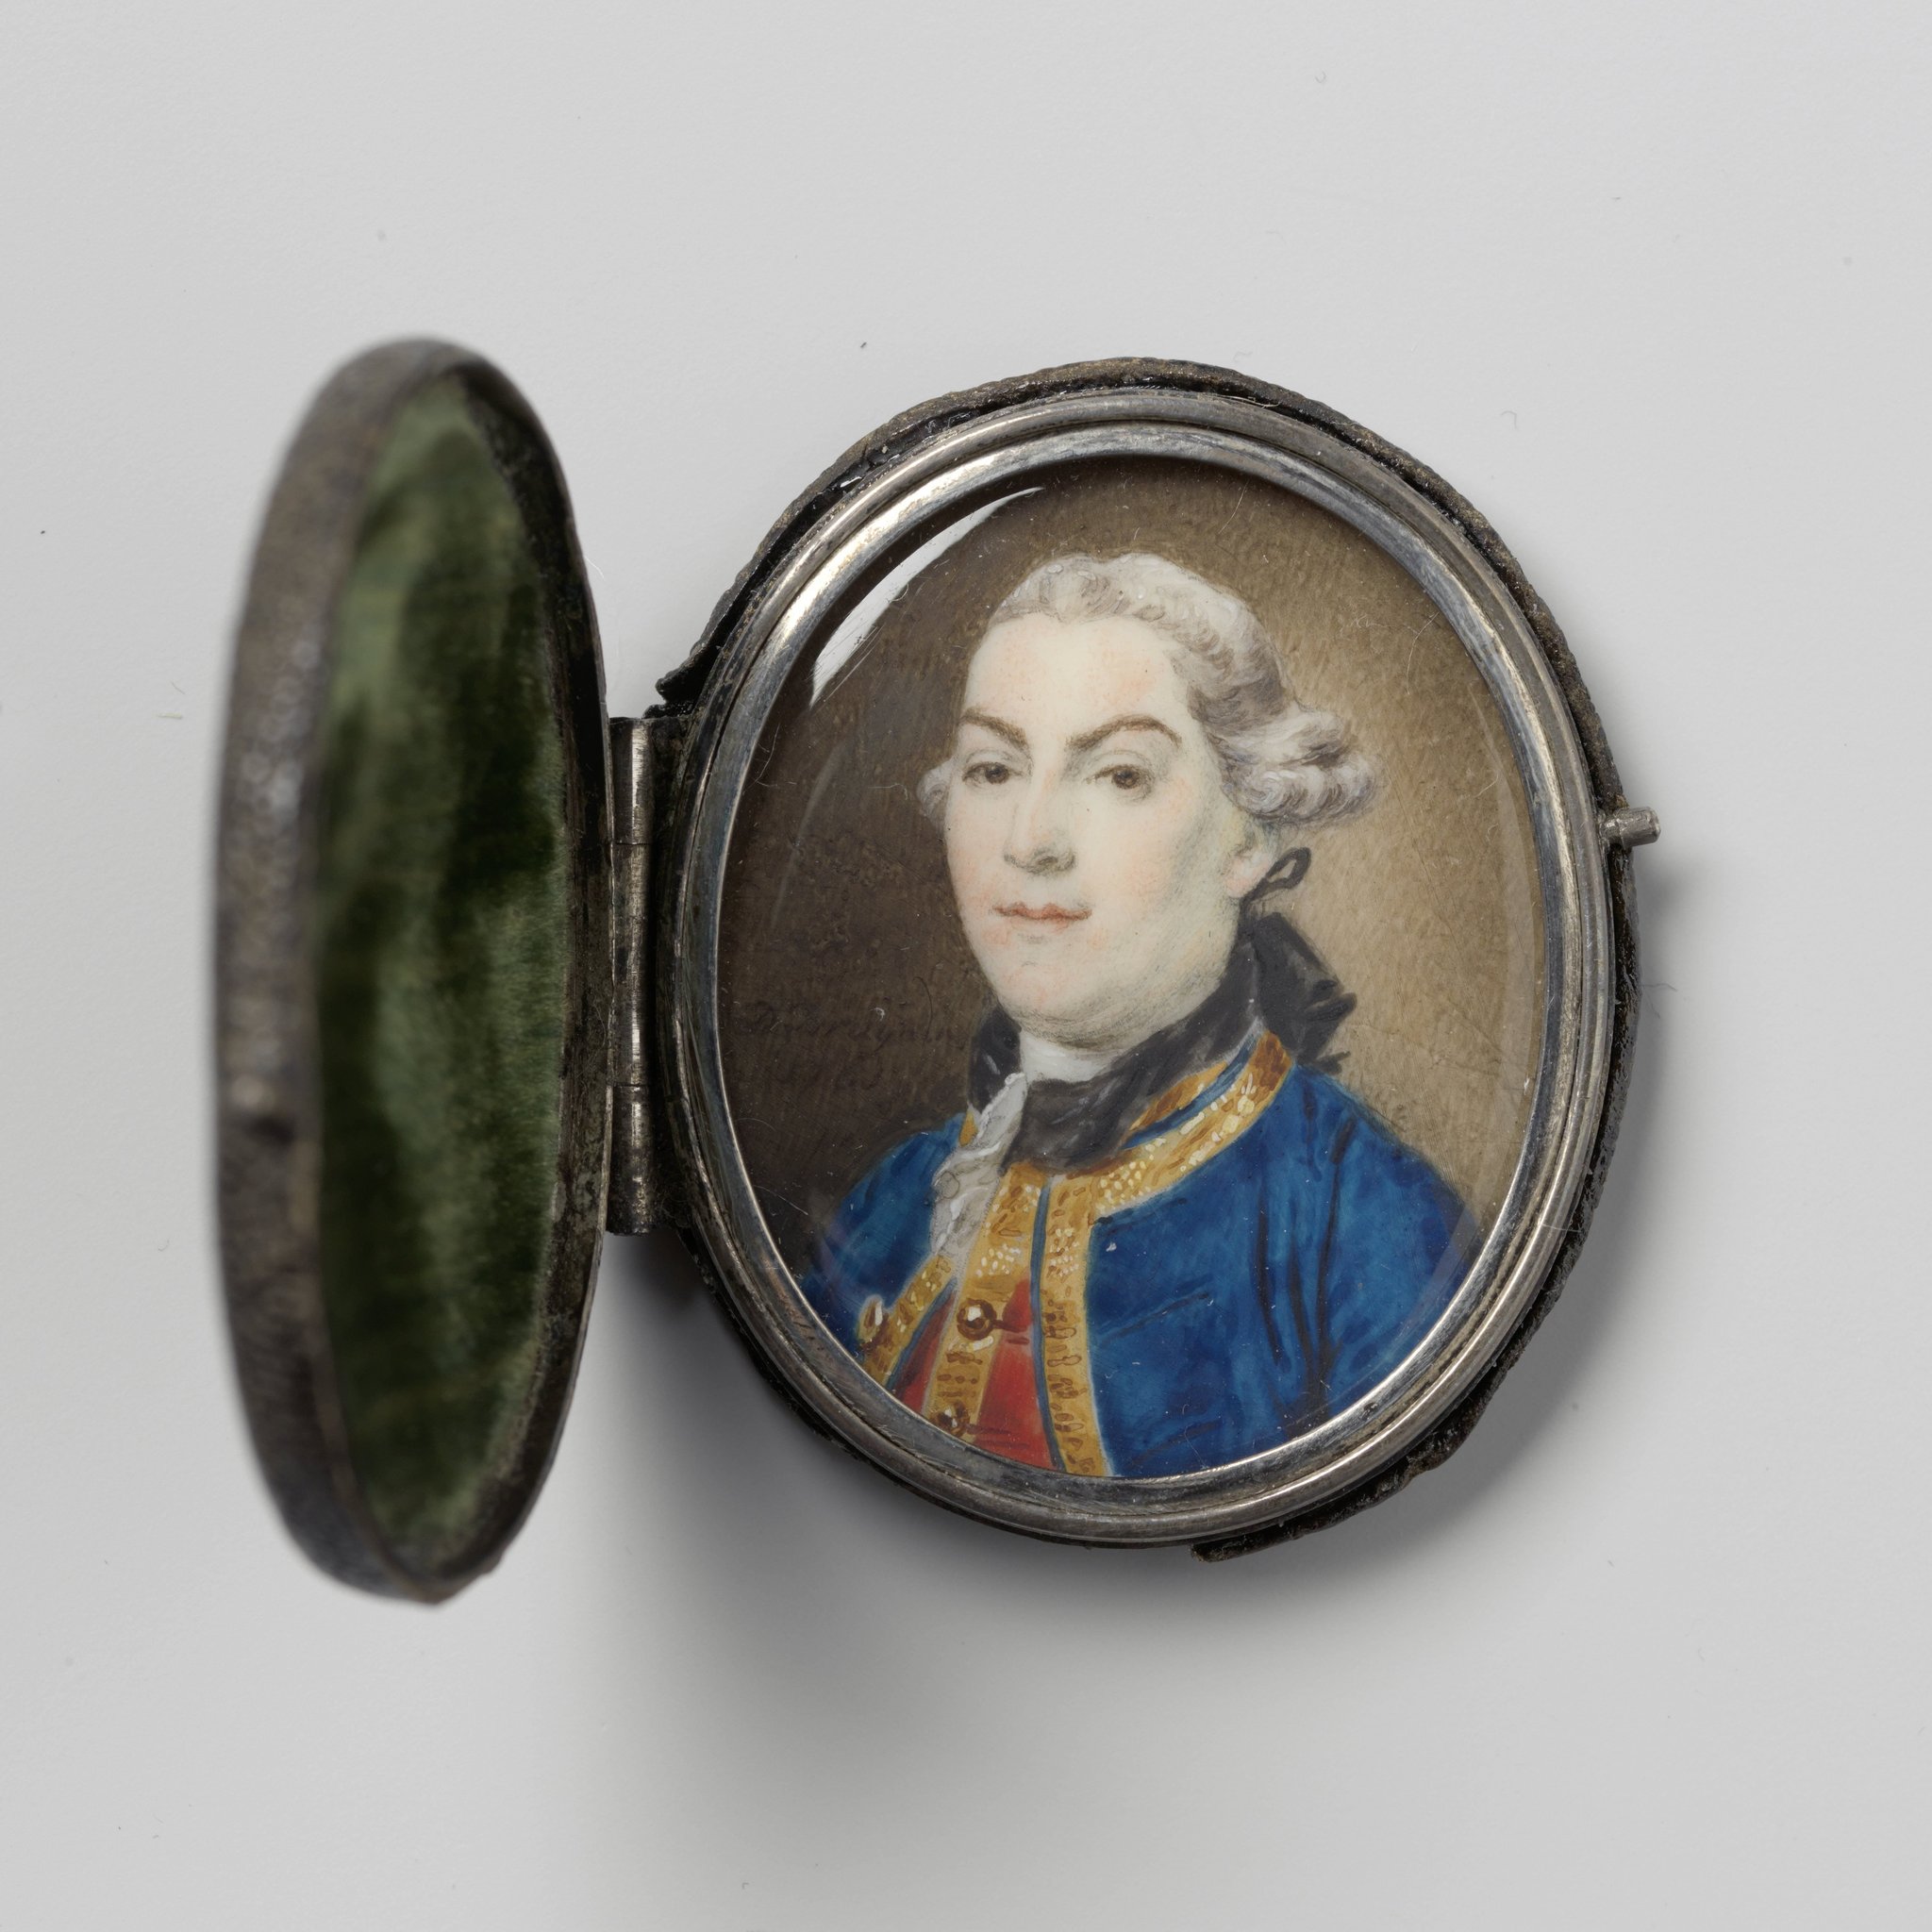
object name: painting, miniature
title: Portrait of a Man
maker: daniël bruyninx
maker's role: painter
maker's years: 1724-1787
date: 1761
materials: glass, ivory, leather, metal, textile, watercolor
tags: historical persons not known by name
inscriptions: signature and date: ‘D. Bruyninx 1761’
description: Daniël Bruyninx (1724 - 1787). Portrait of a man Ivory, 1761. Given by Mrs J.H.M. Staring-de Mol van Otterloo, Vorden, 1981.